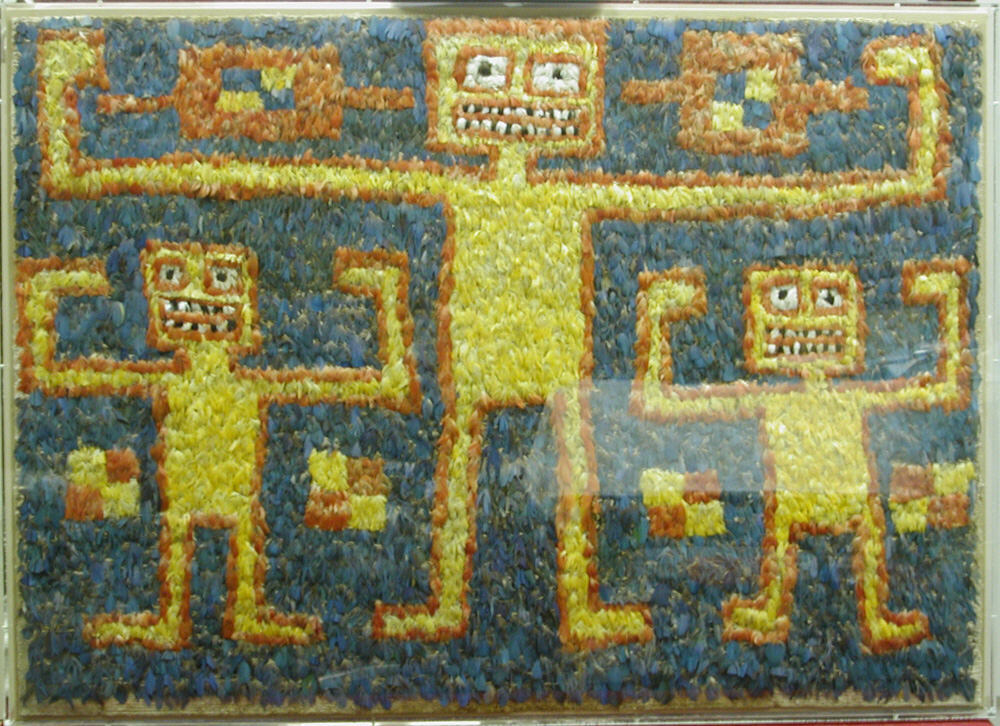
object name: tunic panel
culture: nasca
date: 600-1000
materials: cotton, feather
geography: peru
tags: human figures